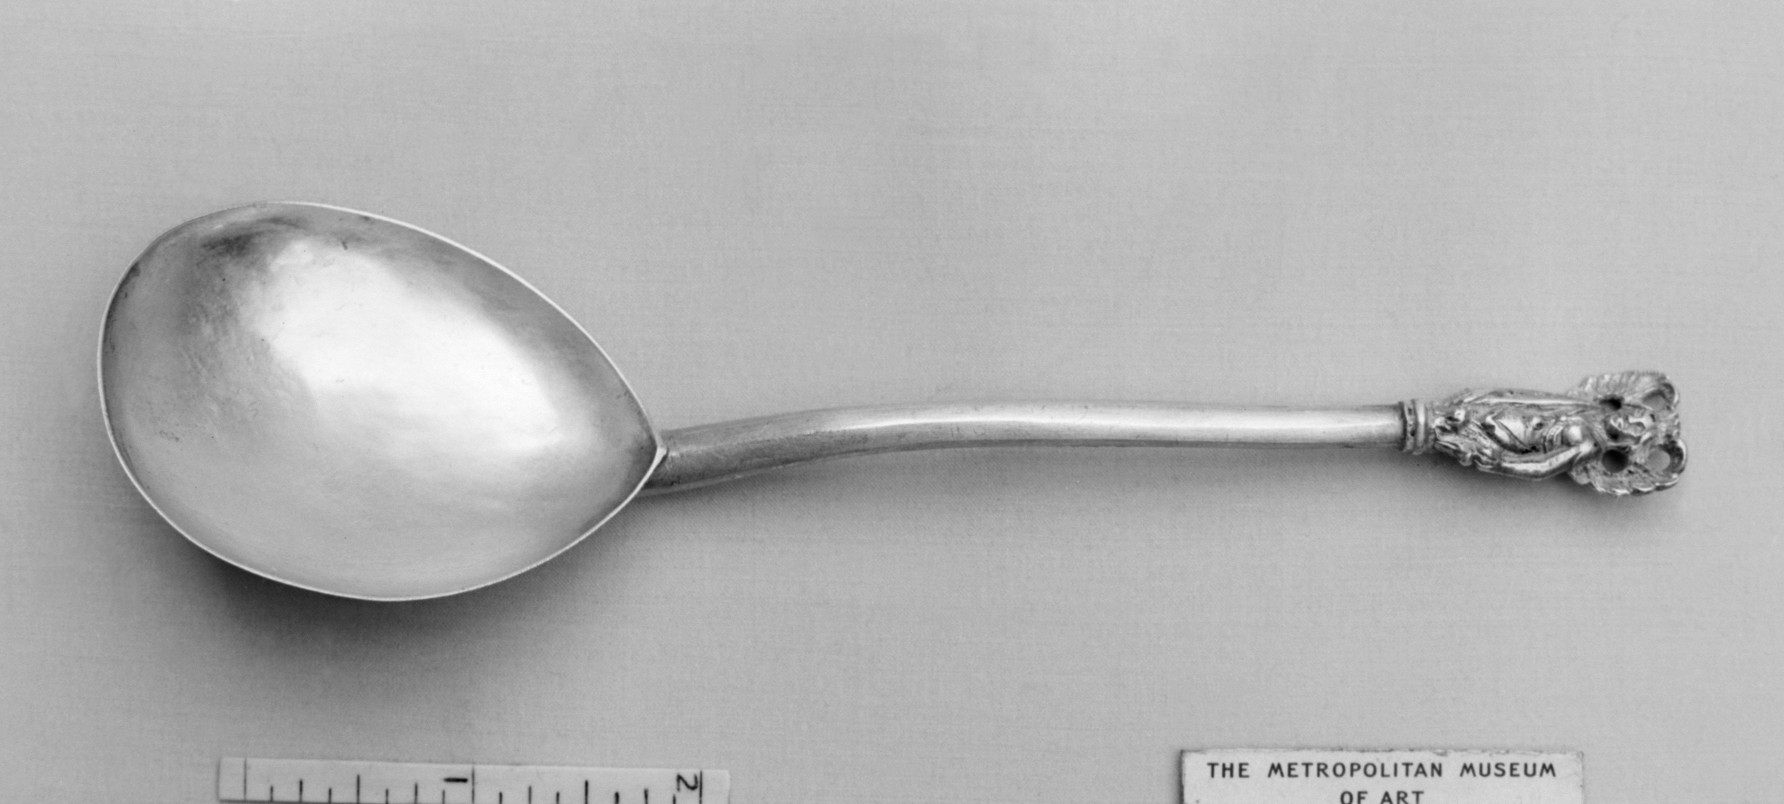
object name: spoon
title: Figure-top spoon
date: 1801-1900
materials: silver